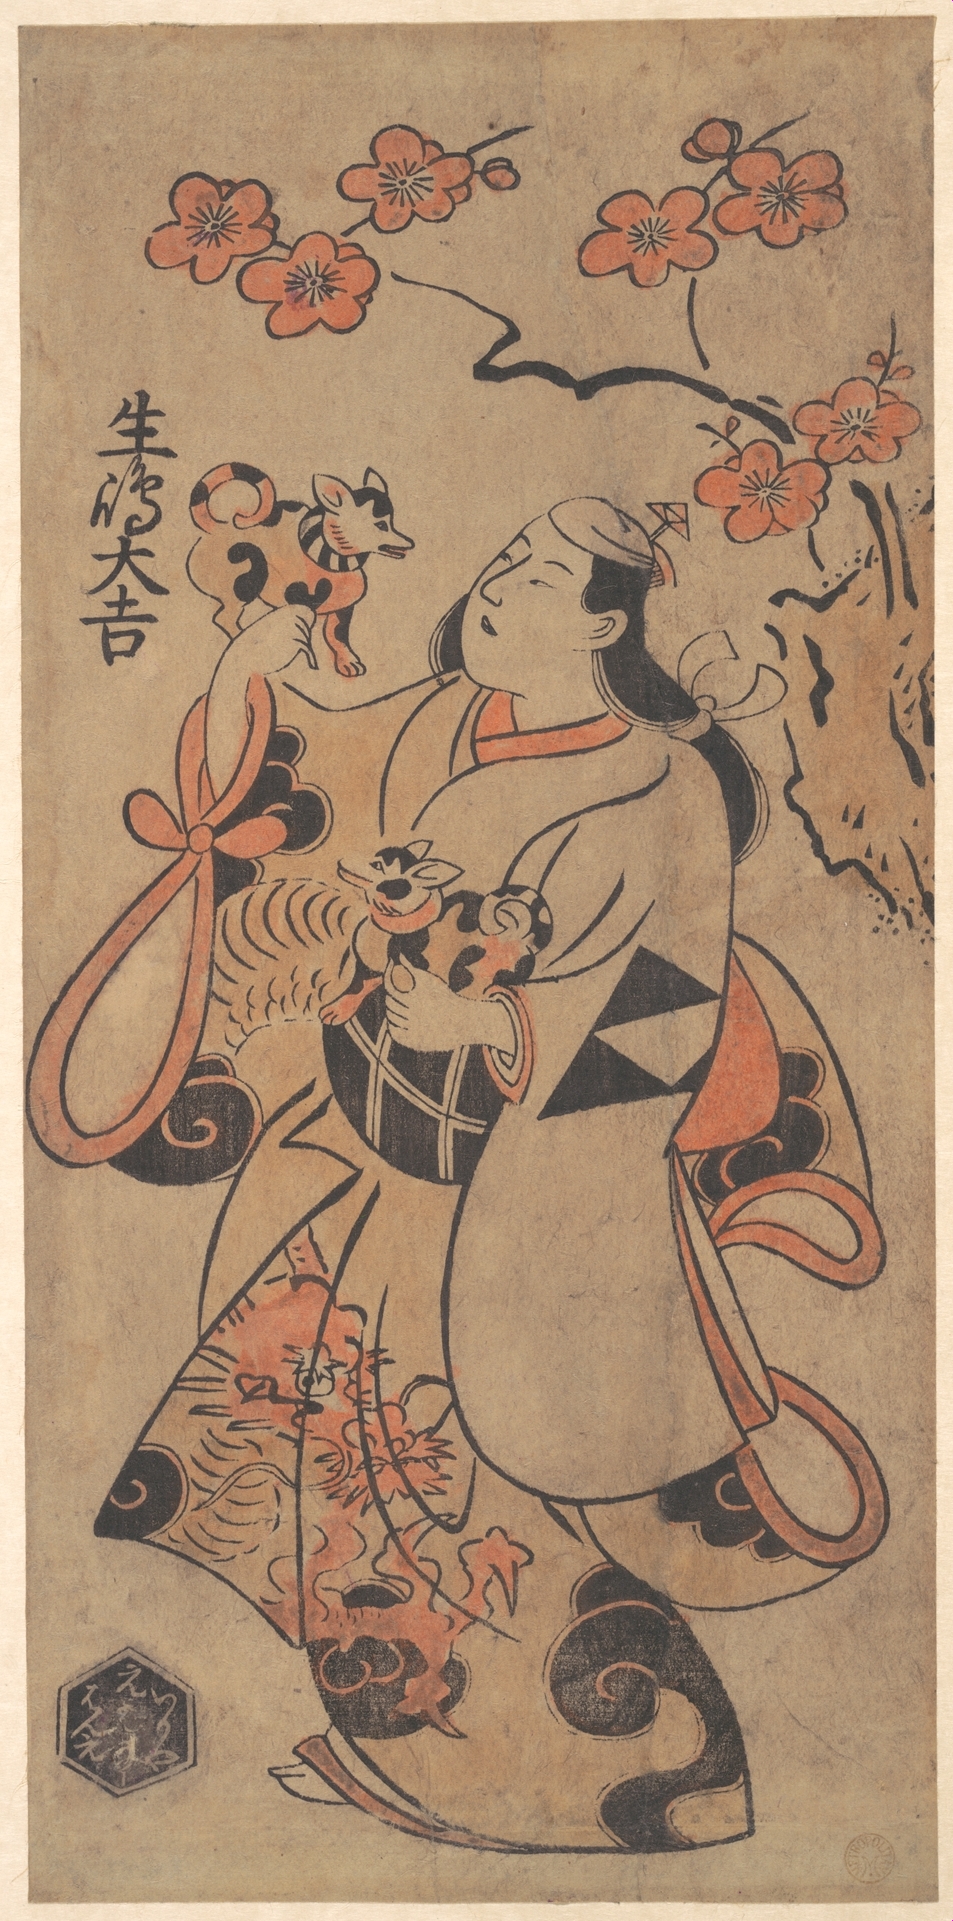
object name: print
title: The Actor Ikushima Daikichi as a Woman Standing under an Ume Tree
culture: japanese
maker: torii kiyonobu i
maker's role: artist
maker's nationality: japanese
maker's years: 1664-1729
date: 1705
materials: ink, paper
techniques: woodblock print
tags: human figures,dogs,flowers,actors